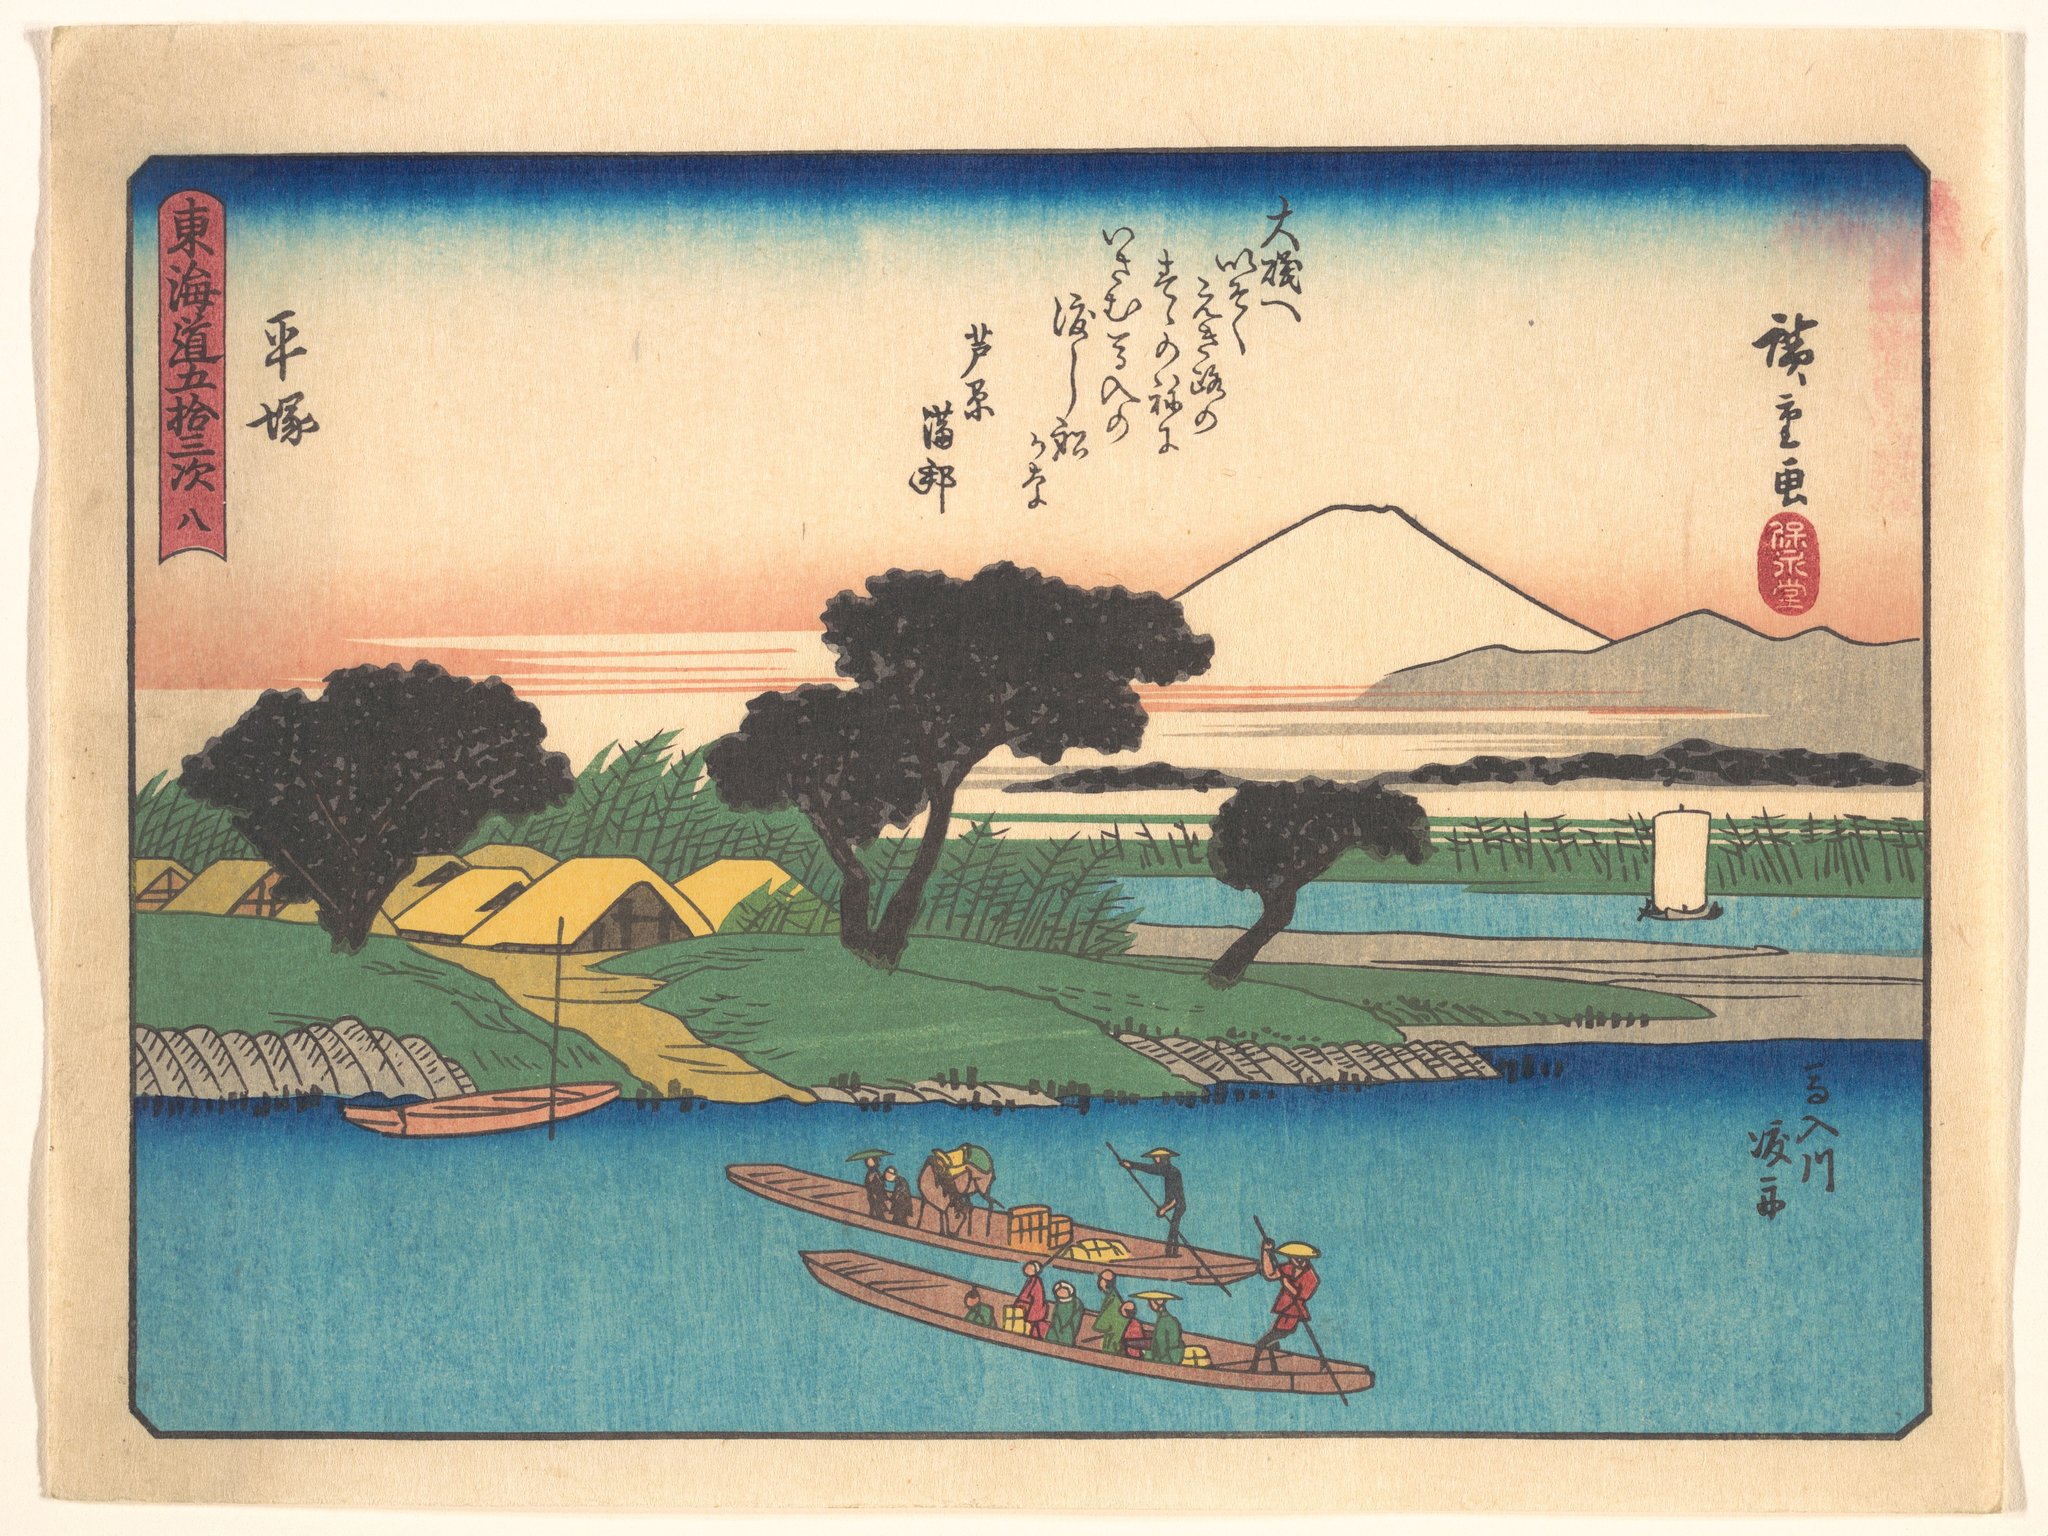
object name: print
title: 東海道五十三次 平塚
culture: japanese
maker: utagawa hiroshige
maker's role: artist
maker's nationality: japanese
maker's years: 1797-1858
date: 1901-1933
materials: ink, paper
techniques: woodblock print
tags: human figures,houses,landscapes,trees,boats